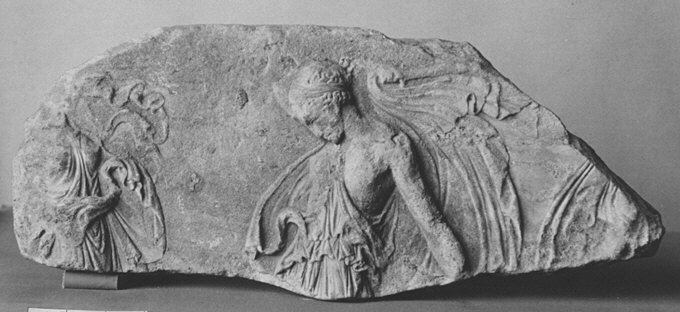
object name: relief fragment with dancing maenad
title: Fragment of a marble relief with dancing maenads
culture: roman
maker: kallimachos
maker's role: artist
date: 1-200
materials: marble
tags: dancing,maenads